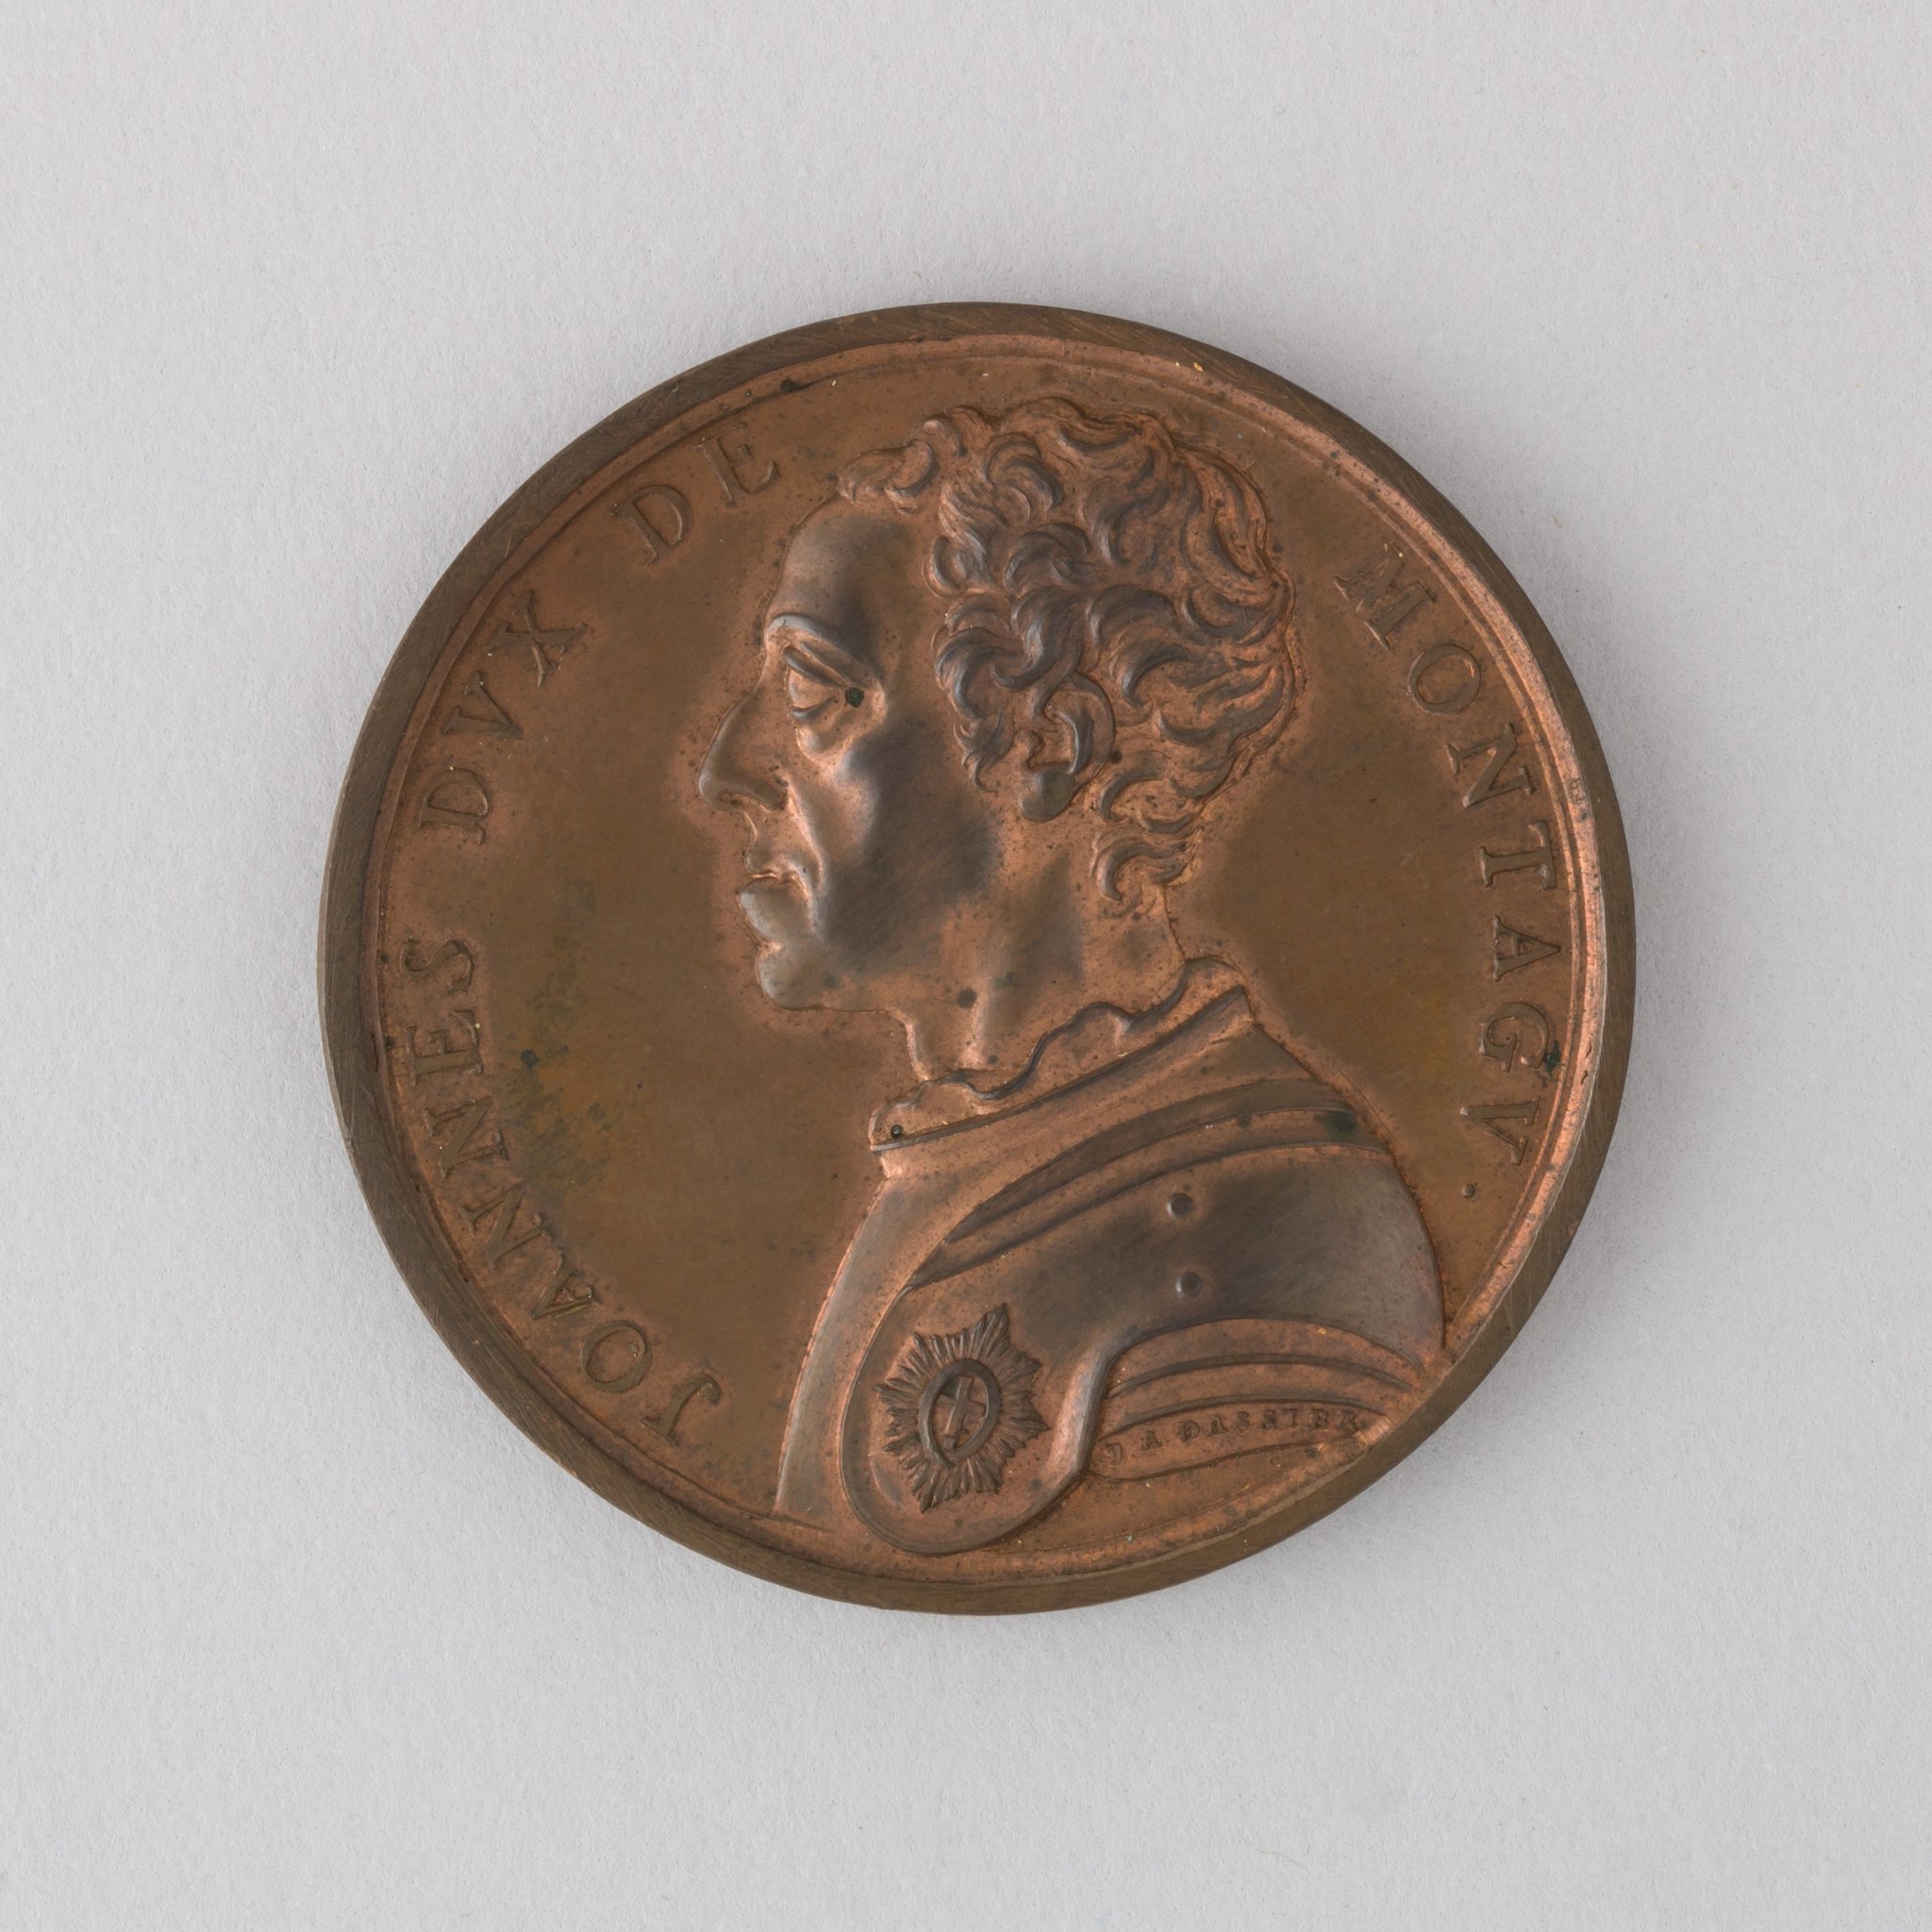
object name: medal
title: Medal Showing John, Second Duke of Montagu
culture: swiss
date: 1751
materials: bronze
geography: switzerland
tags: men,profiles